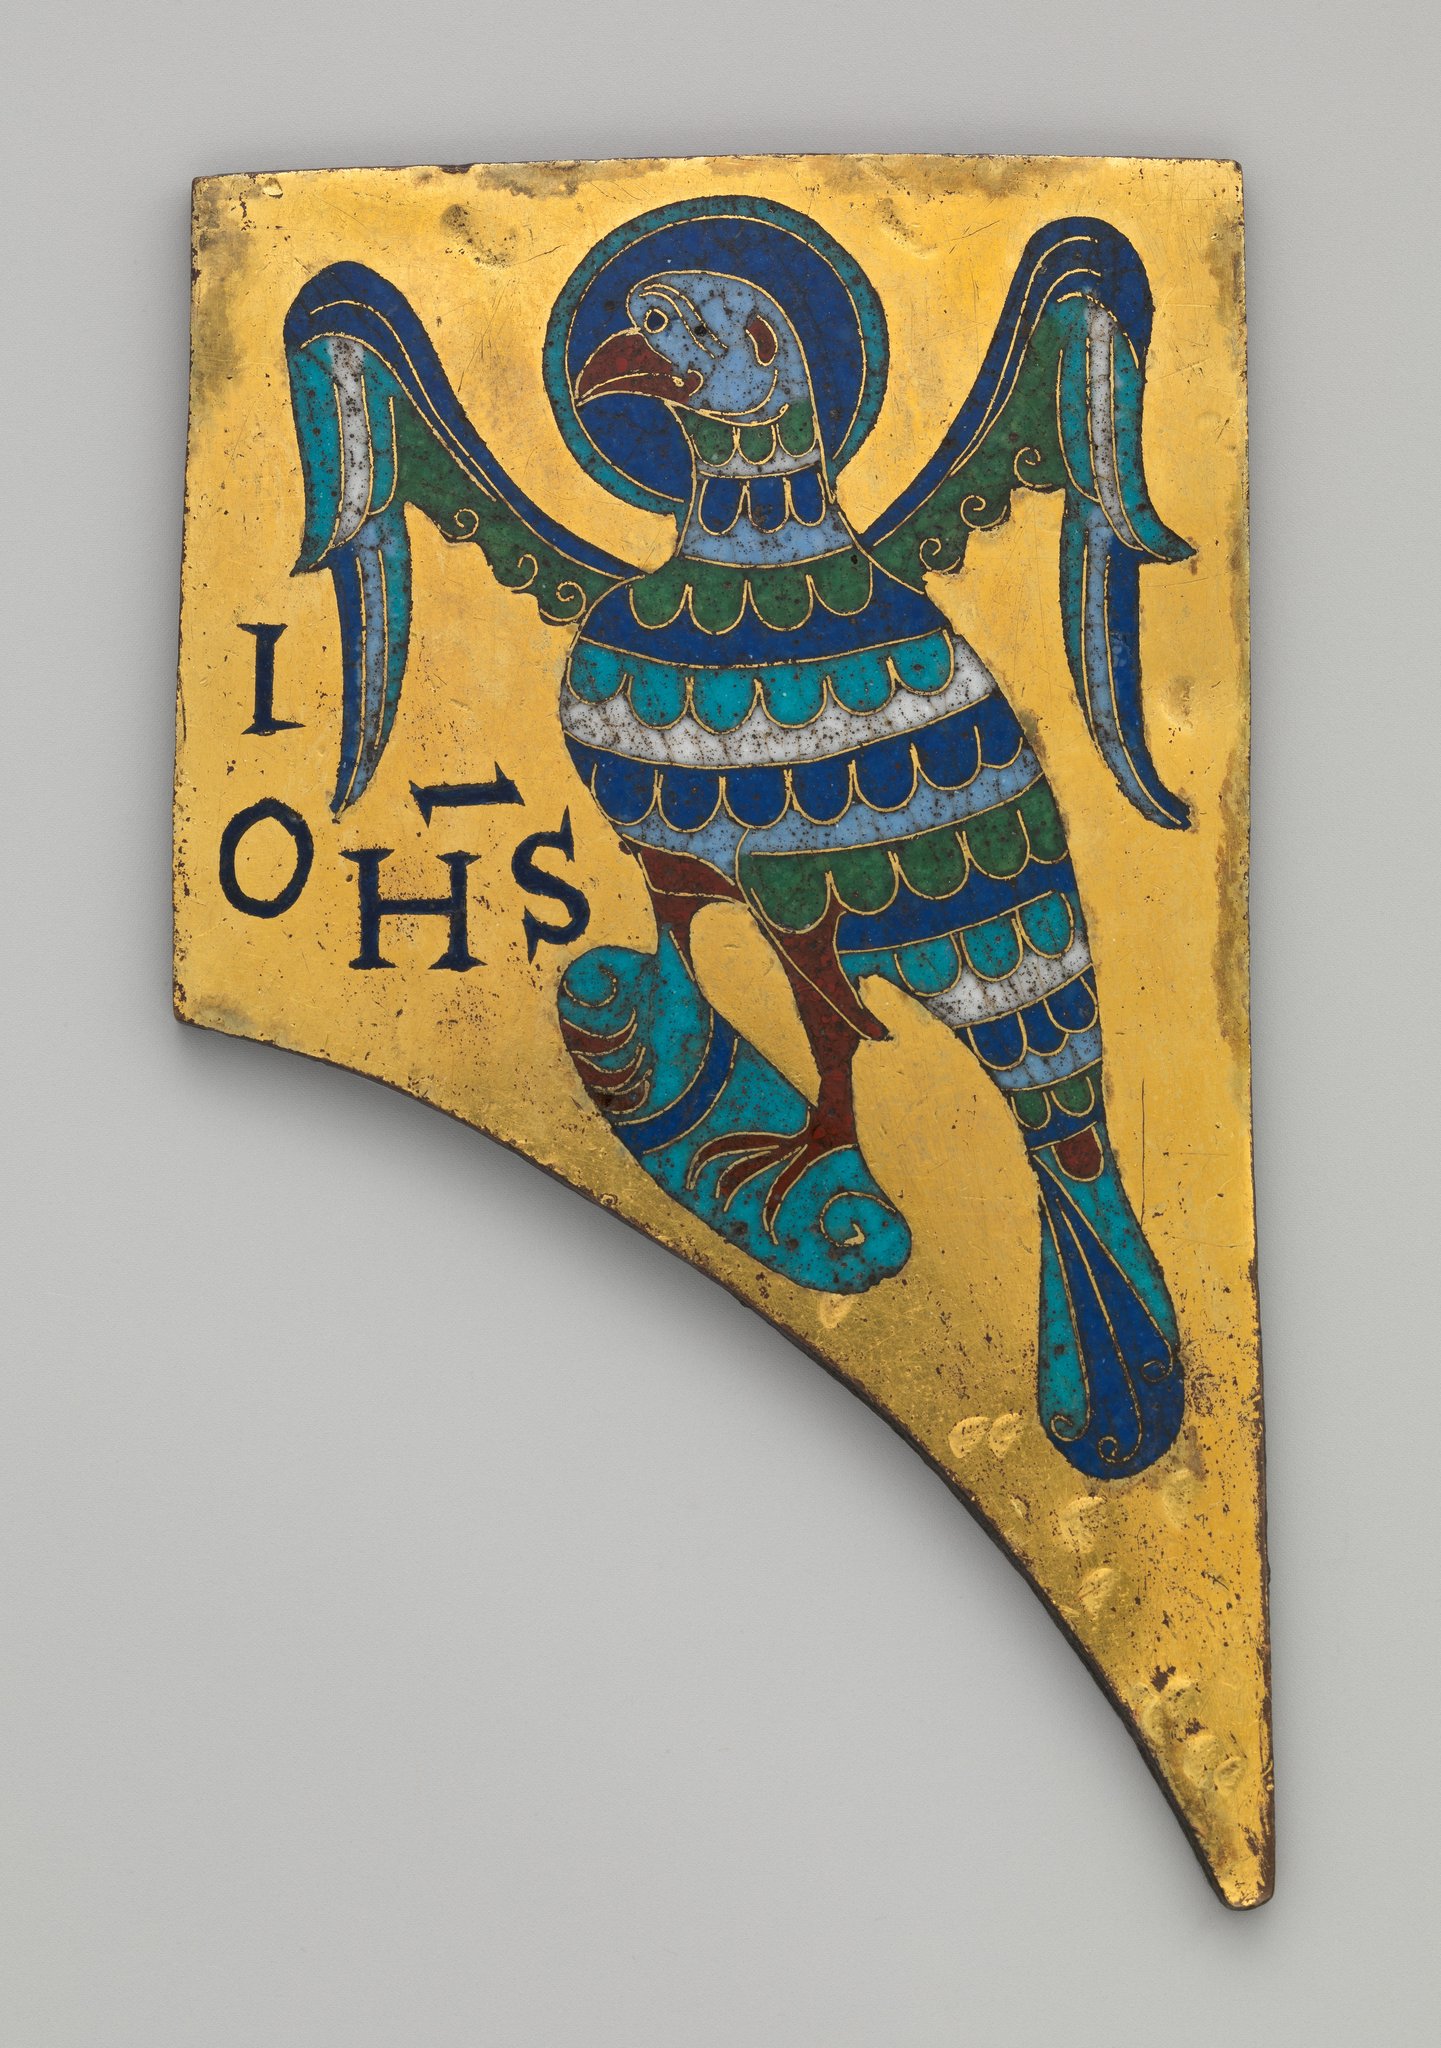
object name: plaque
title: Plaque with the Symbol of the Evangelist John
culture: french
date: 1100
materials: copper, enamel, gilt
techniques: enamel, cutting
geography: france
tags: saint john the evangelist,emblems